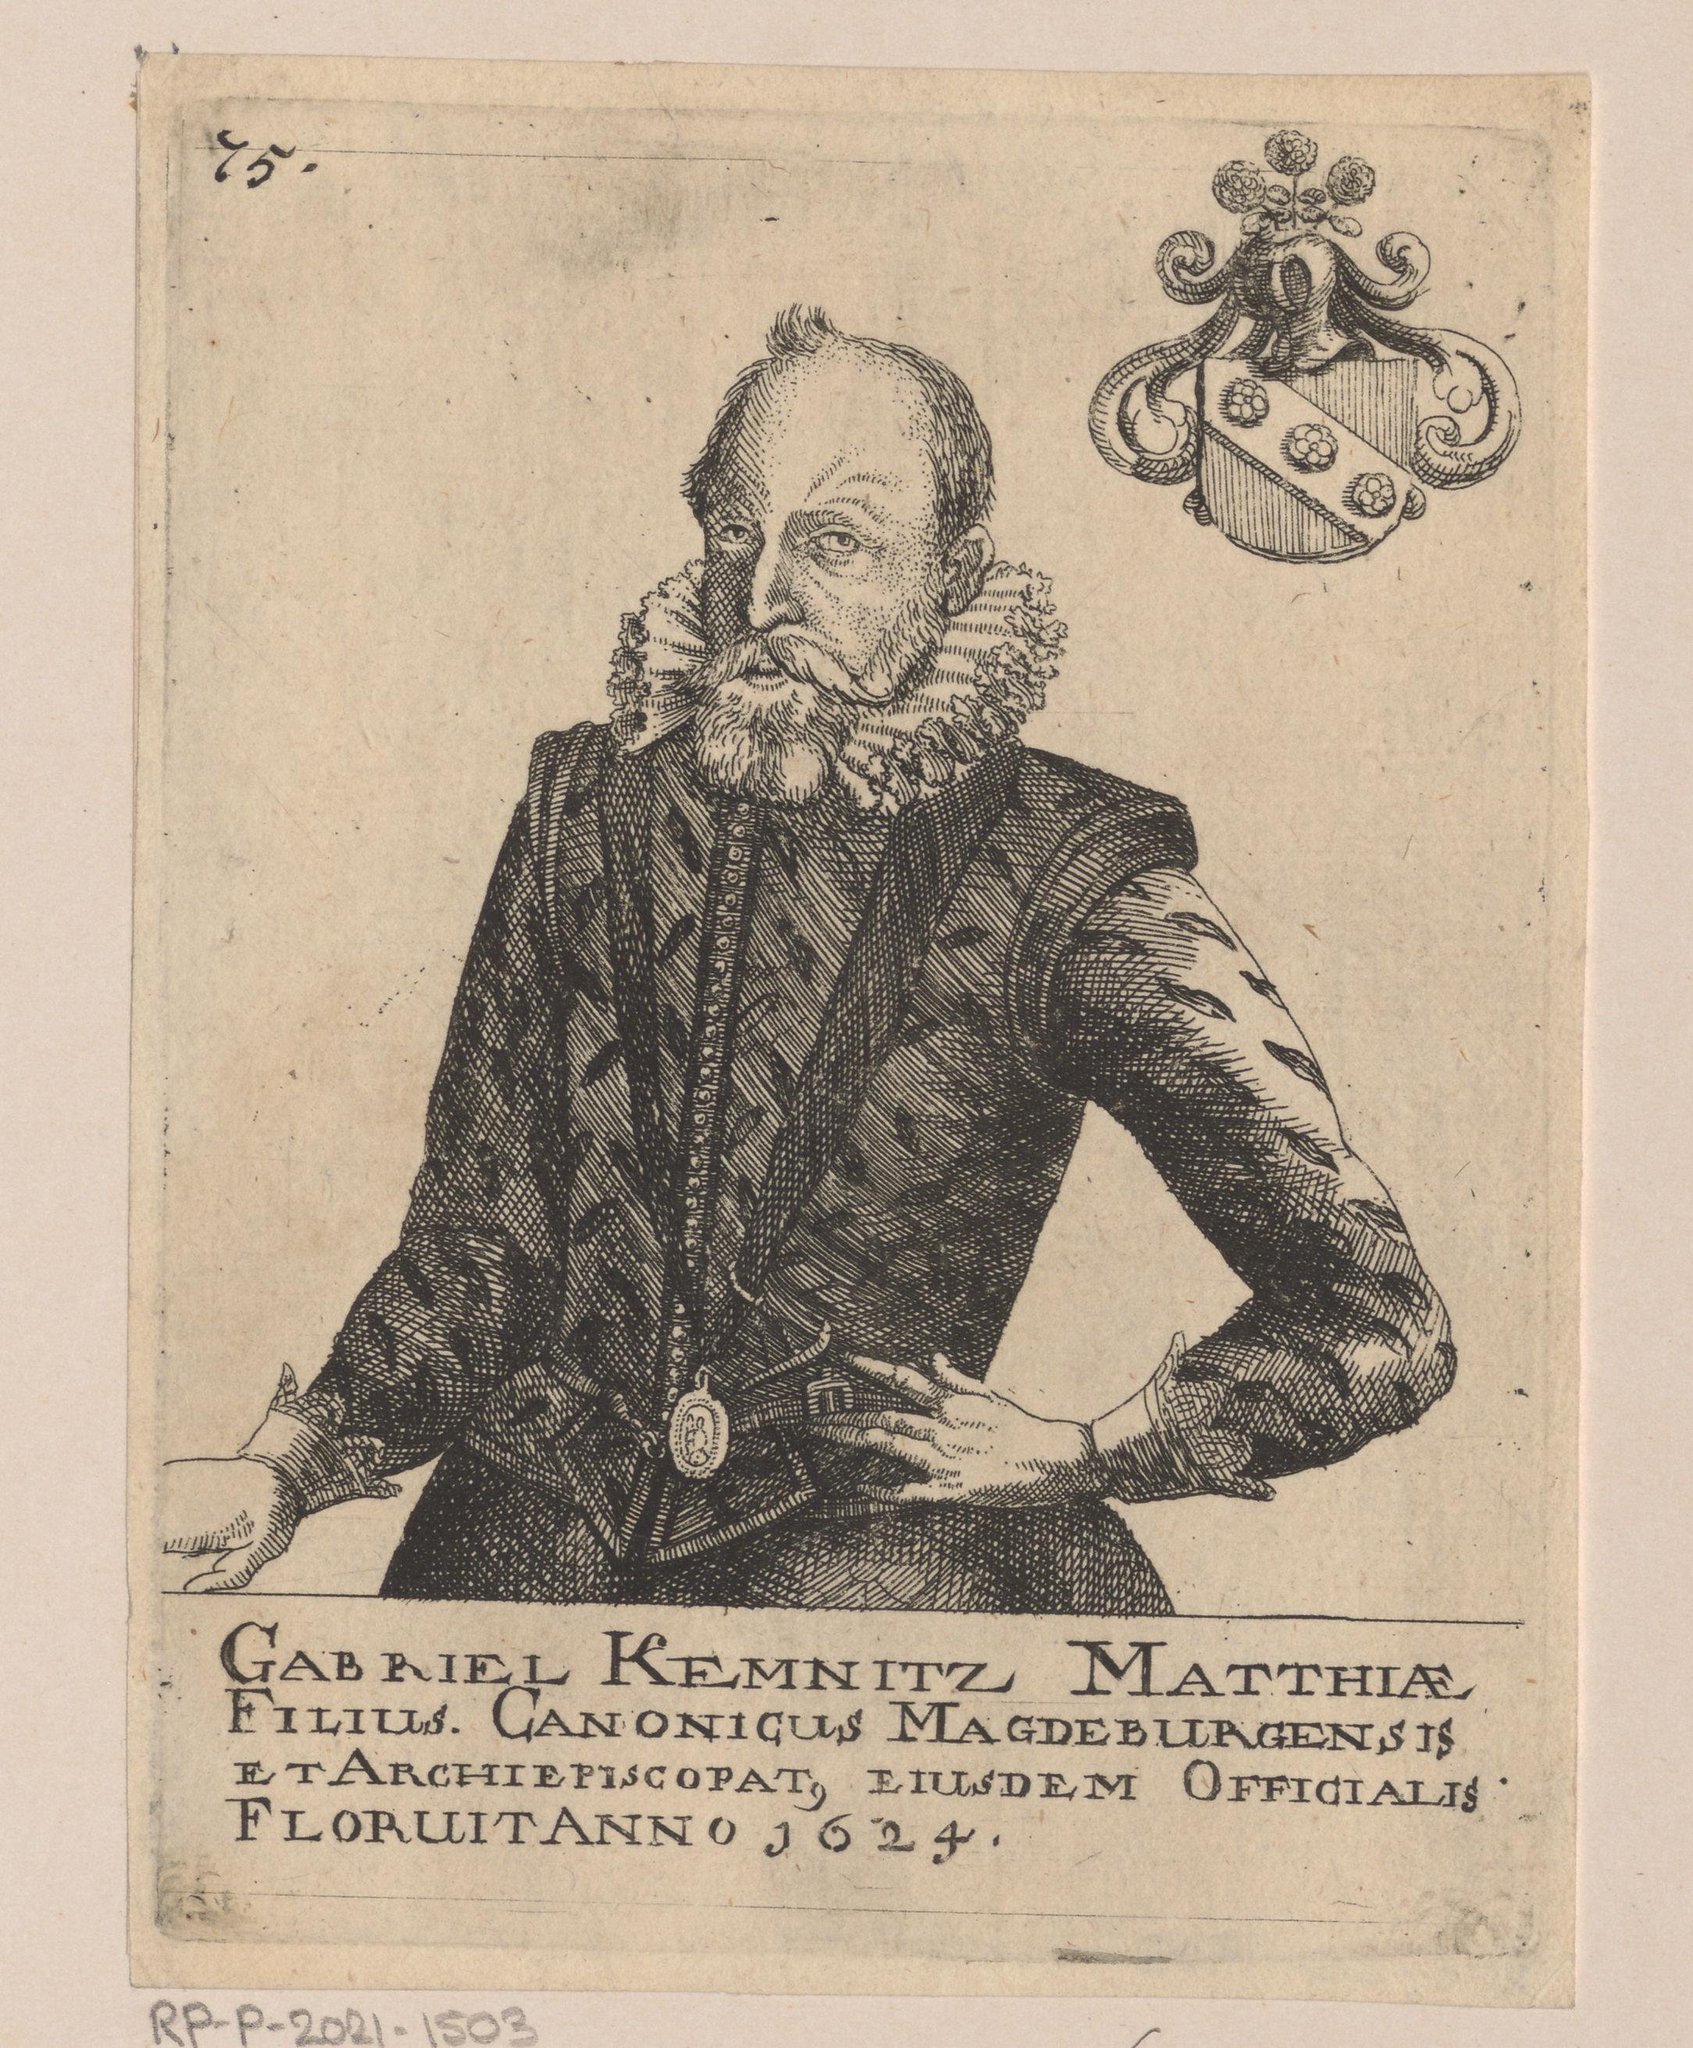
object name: print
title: Portret van Gabriel Chemnitz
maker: Anonymous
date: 1751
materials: paper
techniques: etching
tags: berlin, historical persons, armorial bearing, heraldry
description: Prent mogelijk uit: Küster, Georg Gottfried. Martin Friedrich Seidels Bilder-Sammlung (...). Berlijn: Buchladen bey der Real-Schule, 1751.